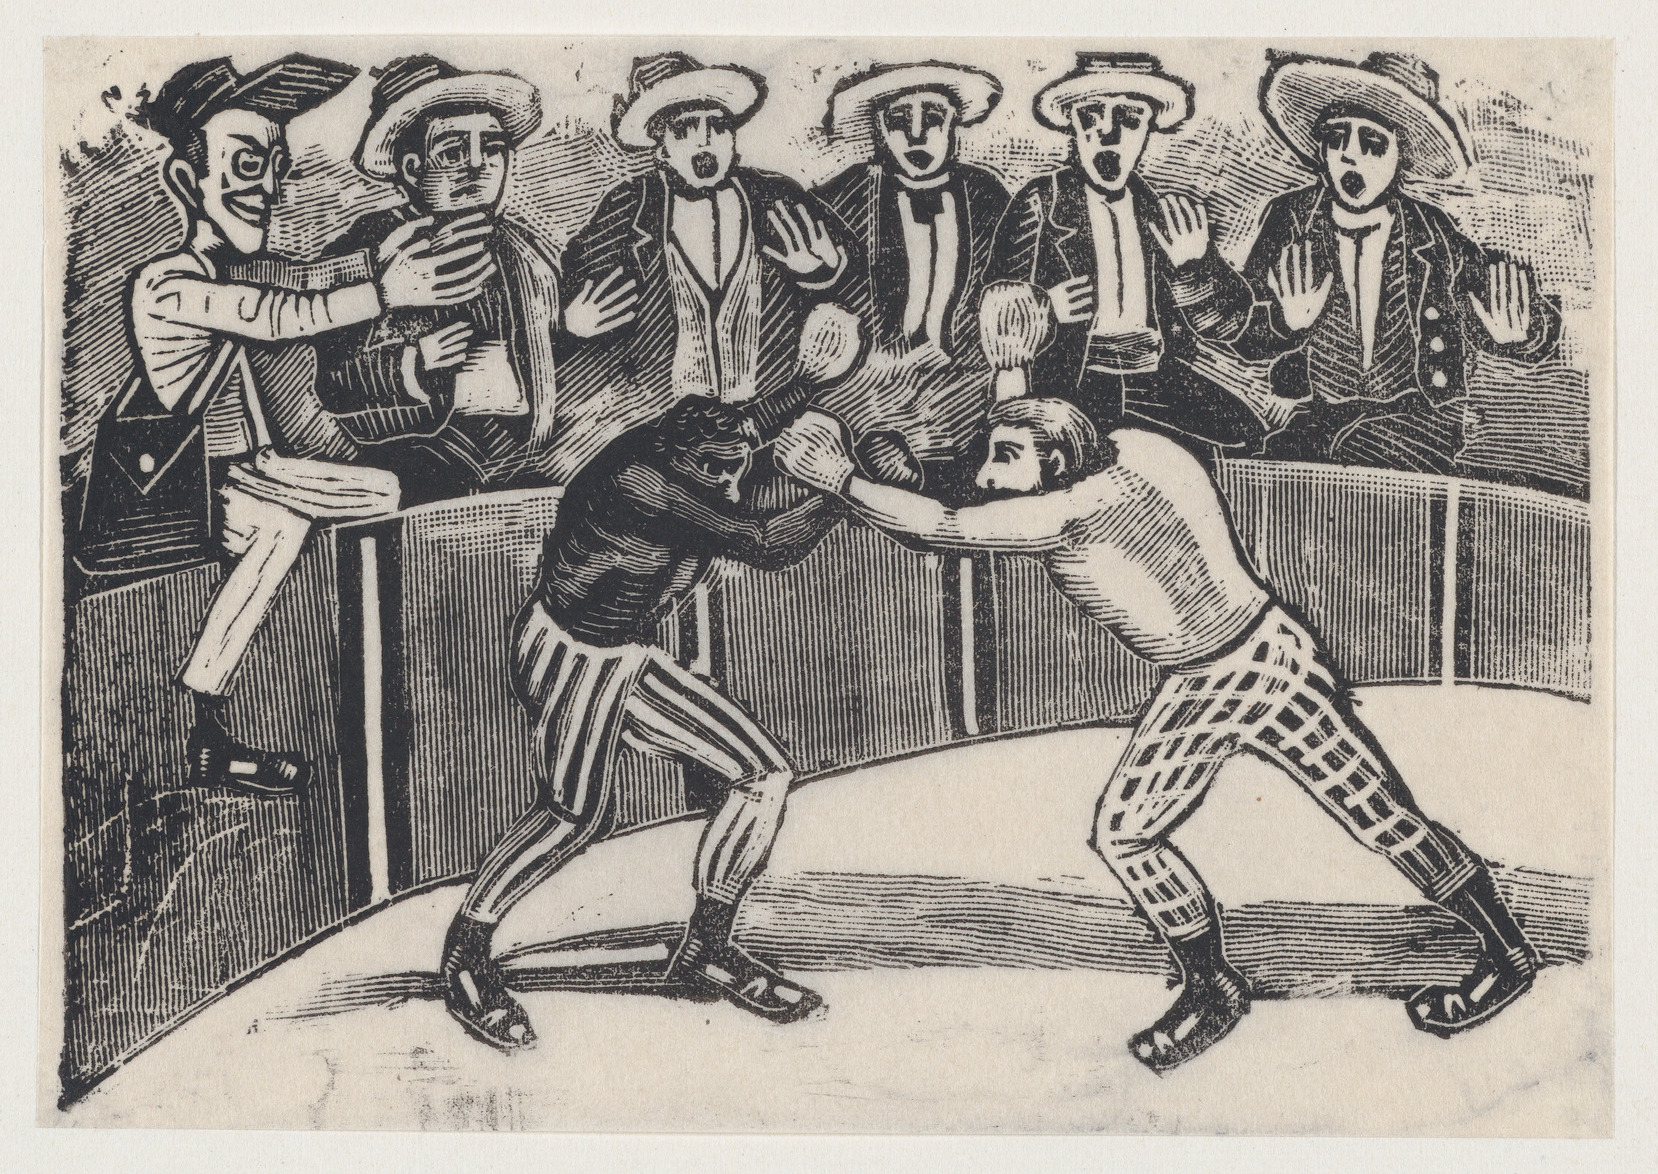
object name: print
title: Don Chepito witnessing a boxing match between two men (one black, the other white)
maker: josé guadalupe posada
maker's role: artist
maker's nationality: mexican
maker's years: 1852-1913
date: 1896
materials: metal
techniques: engraving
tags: men,spectators,boxing